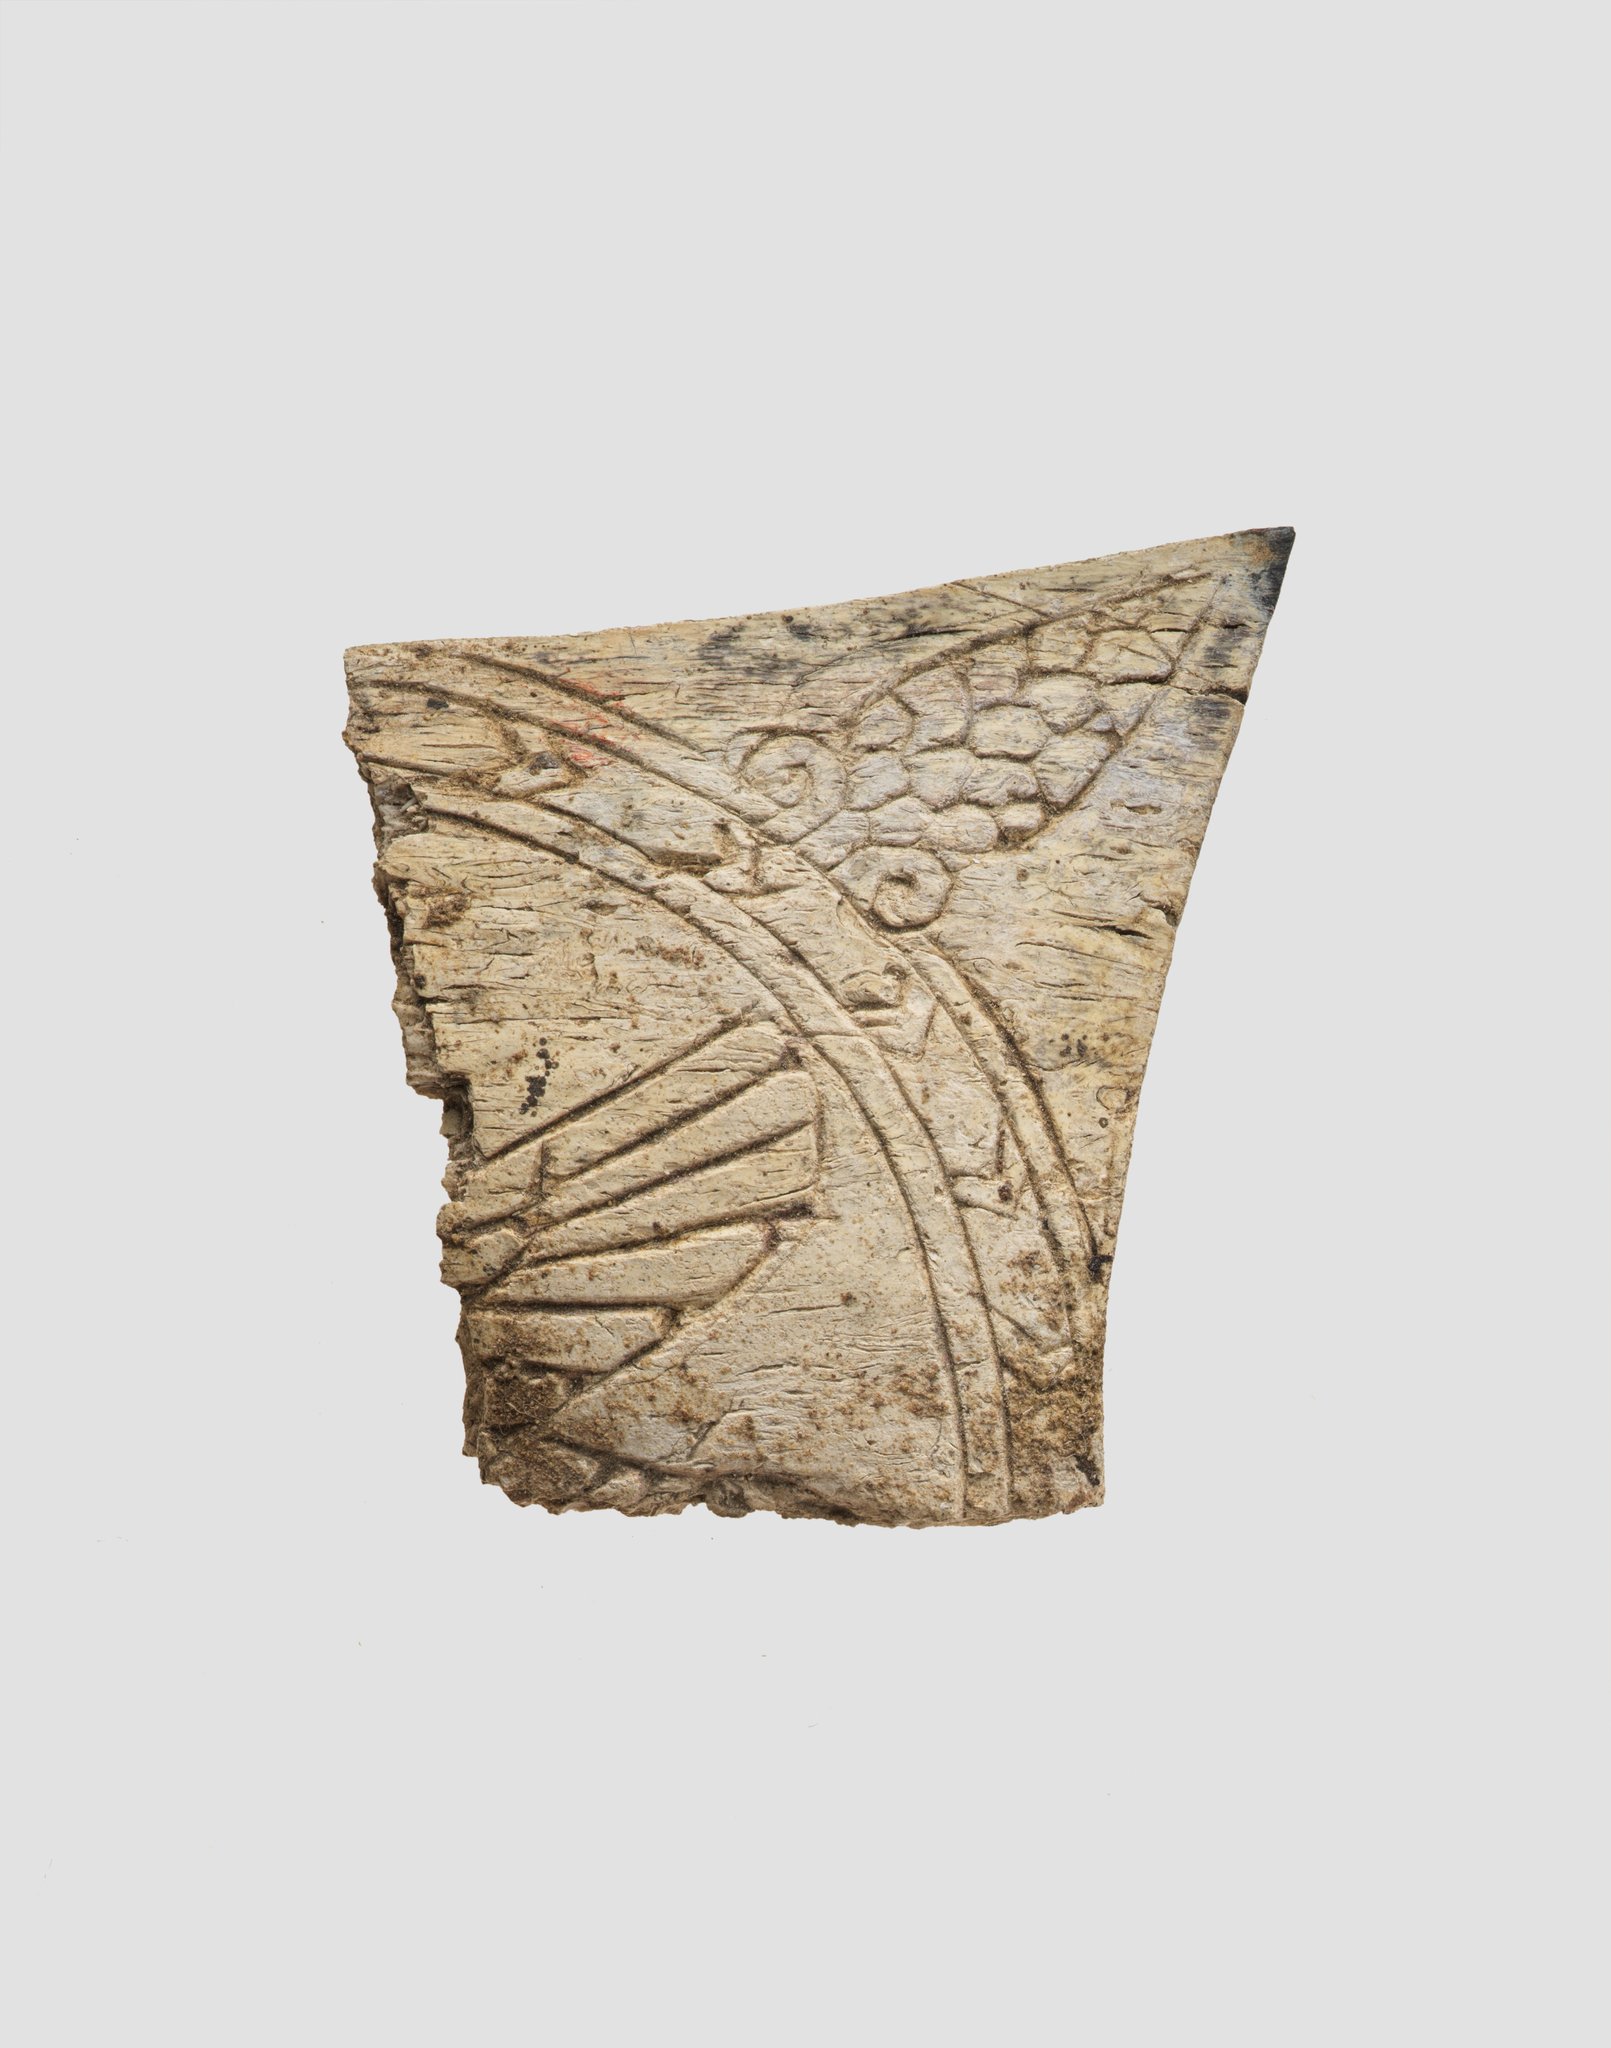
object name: relief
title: Plaque fragment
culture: iranian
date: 900-801 BCE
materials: ivory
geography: iran